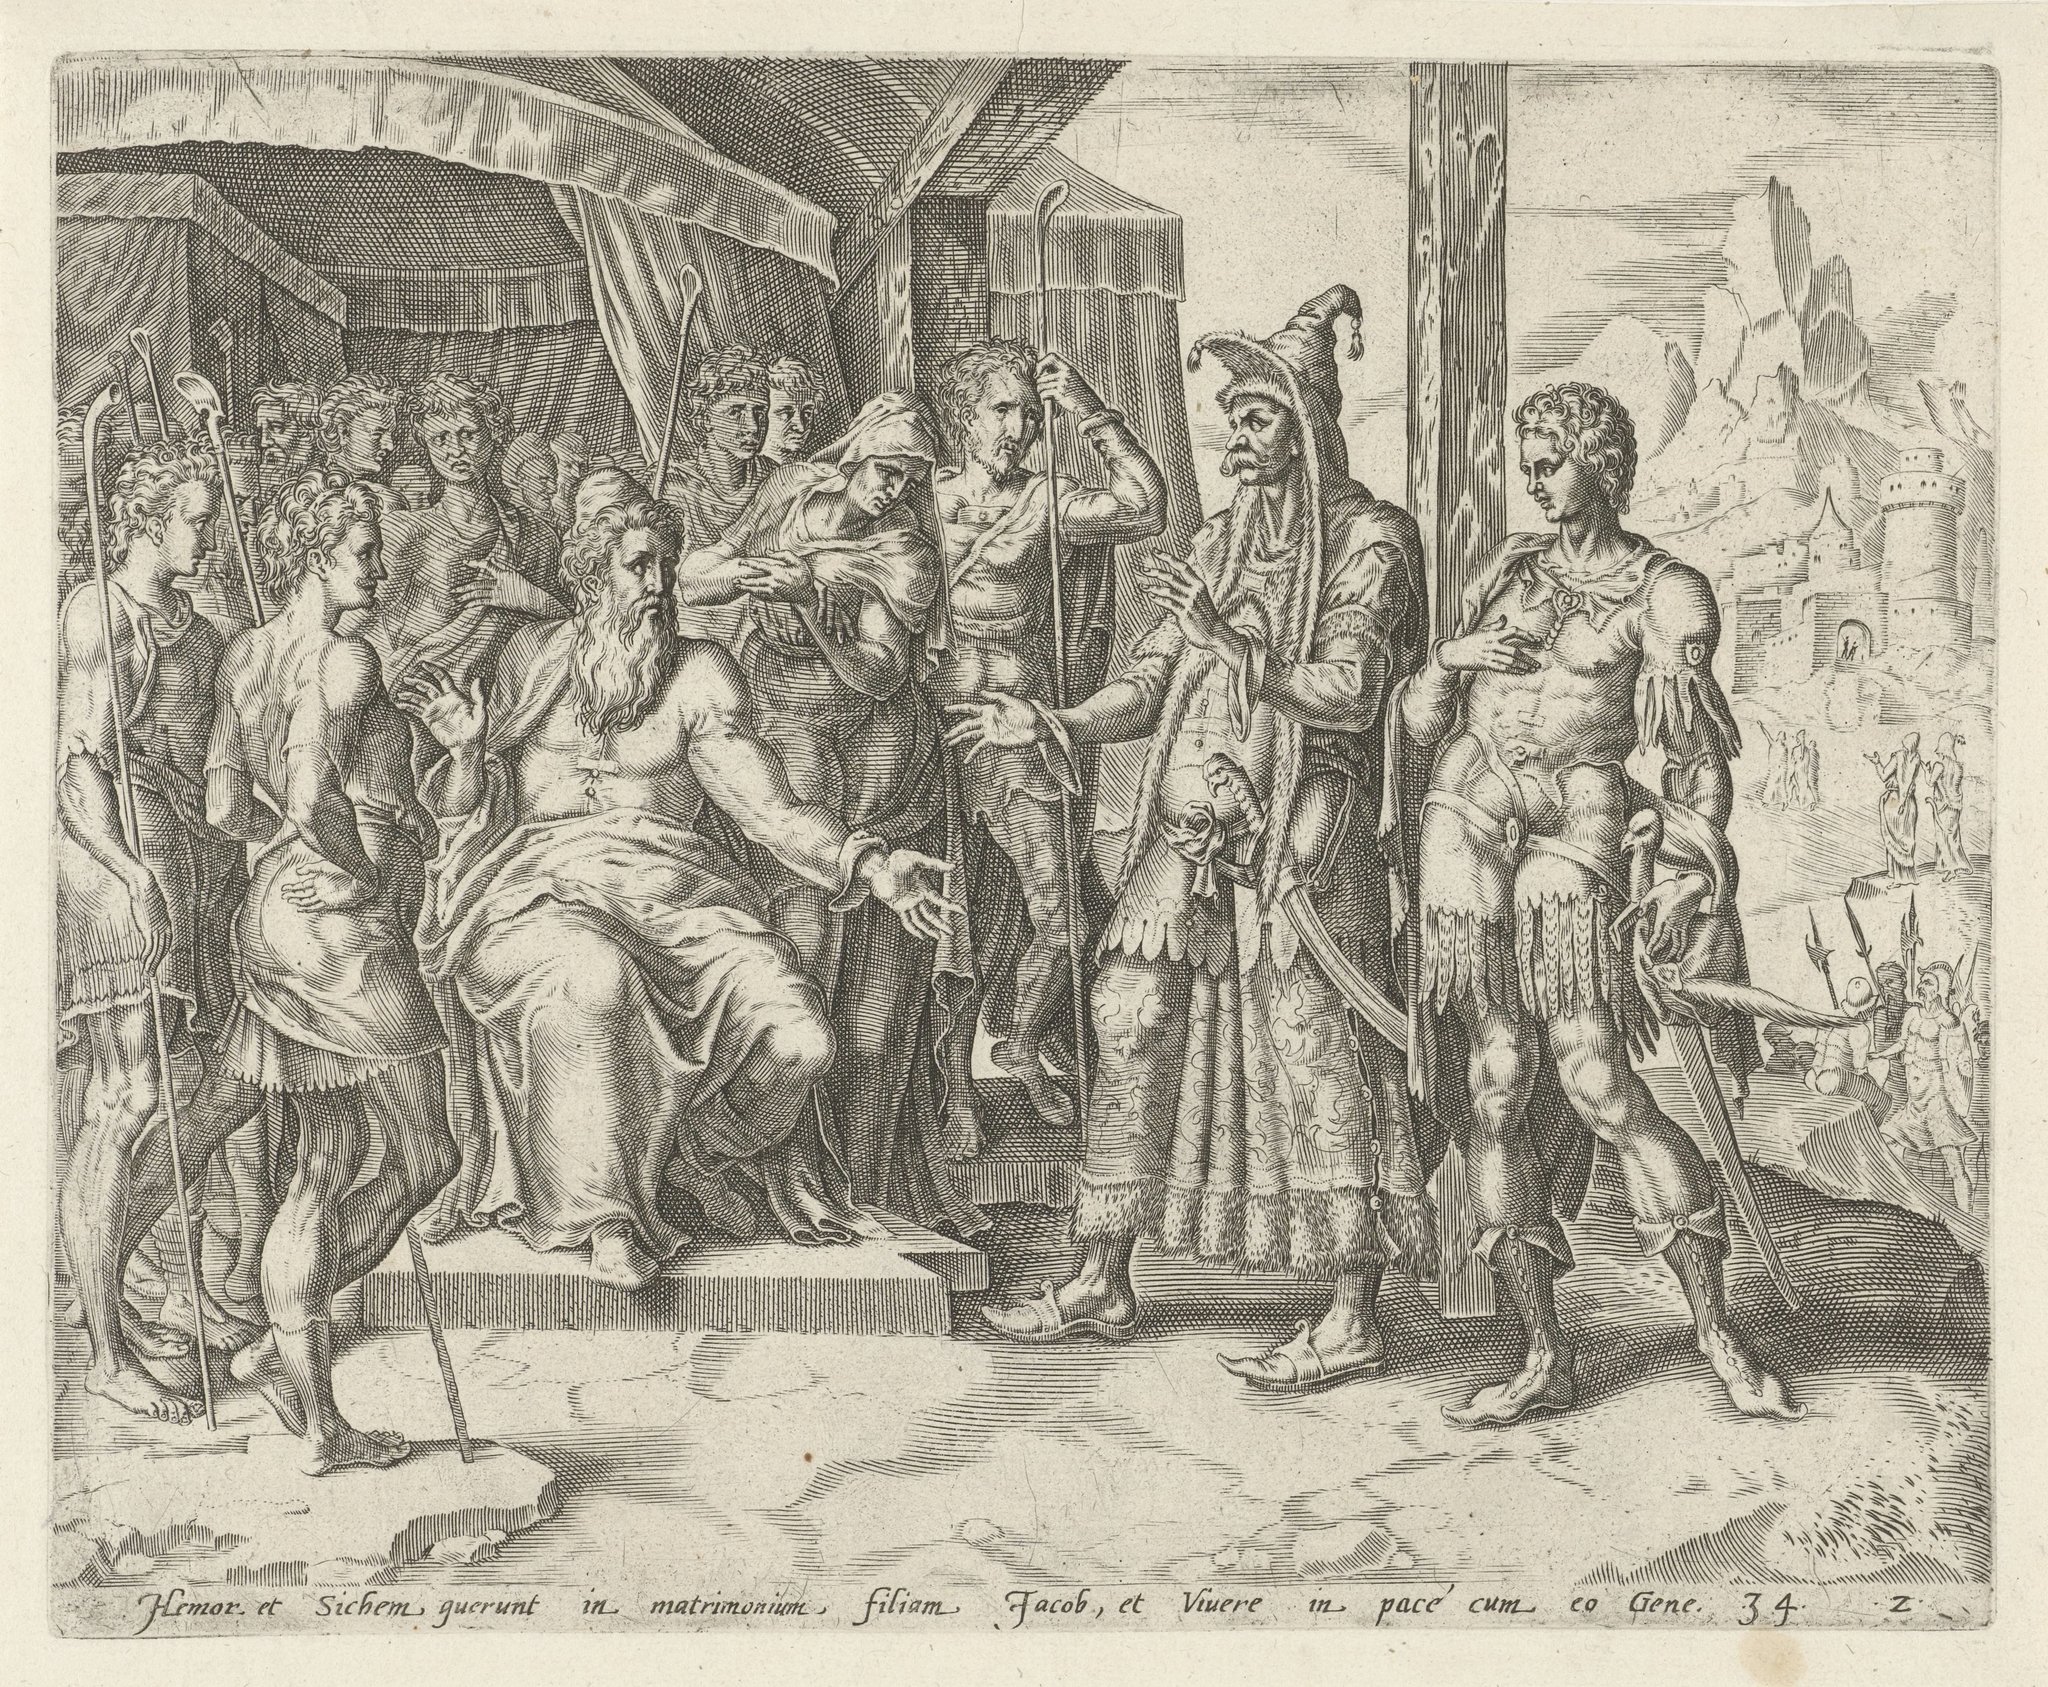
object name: print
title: Geschiedenis van Dina en Sichem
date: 1567-1571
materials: paper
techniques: engraving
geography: antwerp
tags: hamor and shechem come to jacob, whose sons have just come in from the fields, to ask for dinah in marriage; the sons agree on condition that the shechemites will be circumcised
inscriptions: collector's mark: Lugt 2228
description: Sichem en zijn vader Chamor komen bij Jakob en vragen hem om zijn dochter Dina uit te huwelijken aan Sichem. Jakob zit in zijn tent omringd door zijn vrouw en twaalf zonen. Jakobs zonen stellen de voorwaarde dat Sichem en zijn volk besneden moeten worden, omdat ze hun vrouwen alleen aan besneden mannen willen uithuwelijken. Onderaan in de marge een verwijzing in het Latijn naar de Bijbeltekst in Gen. 34.